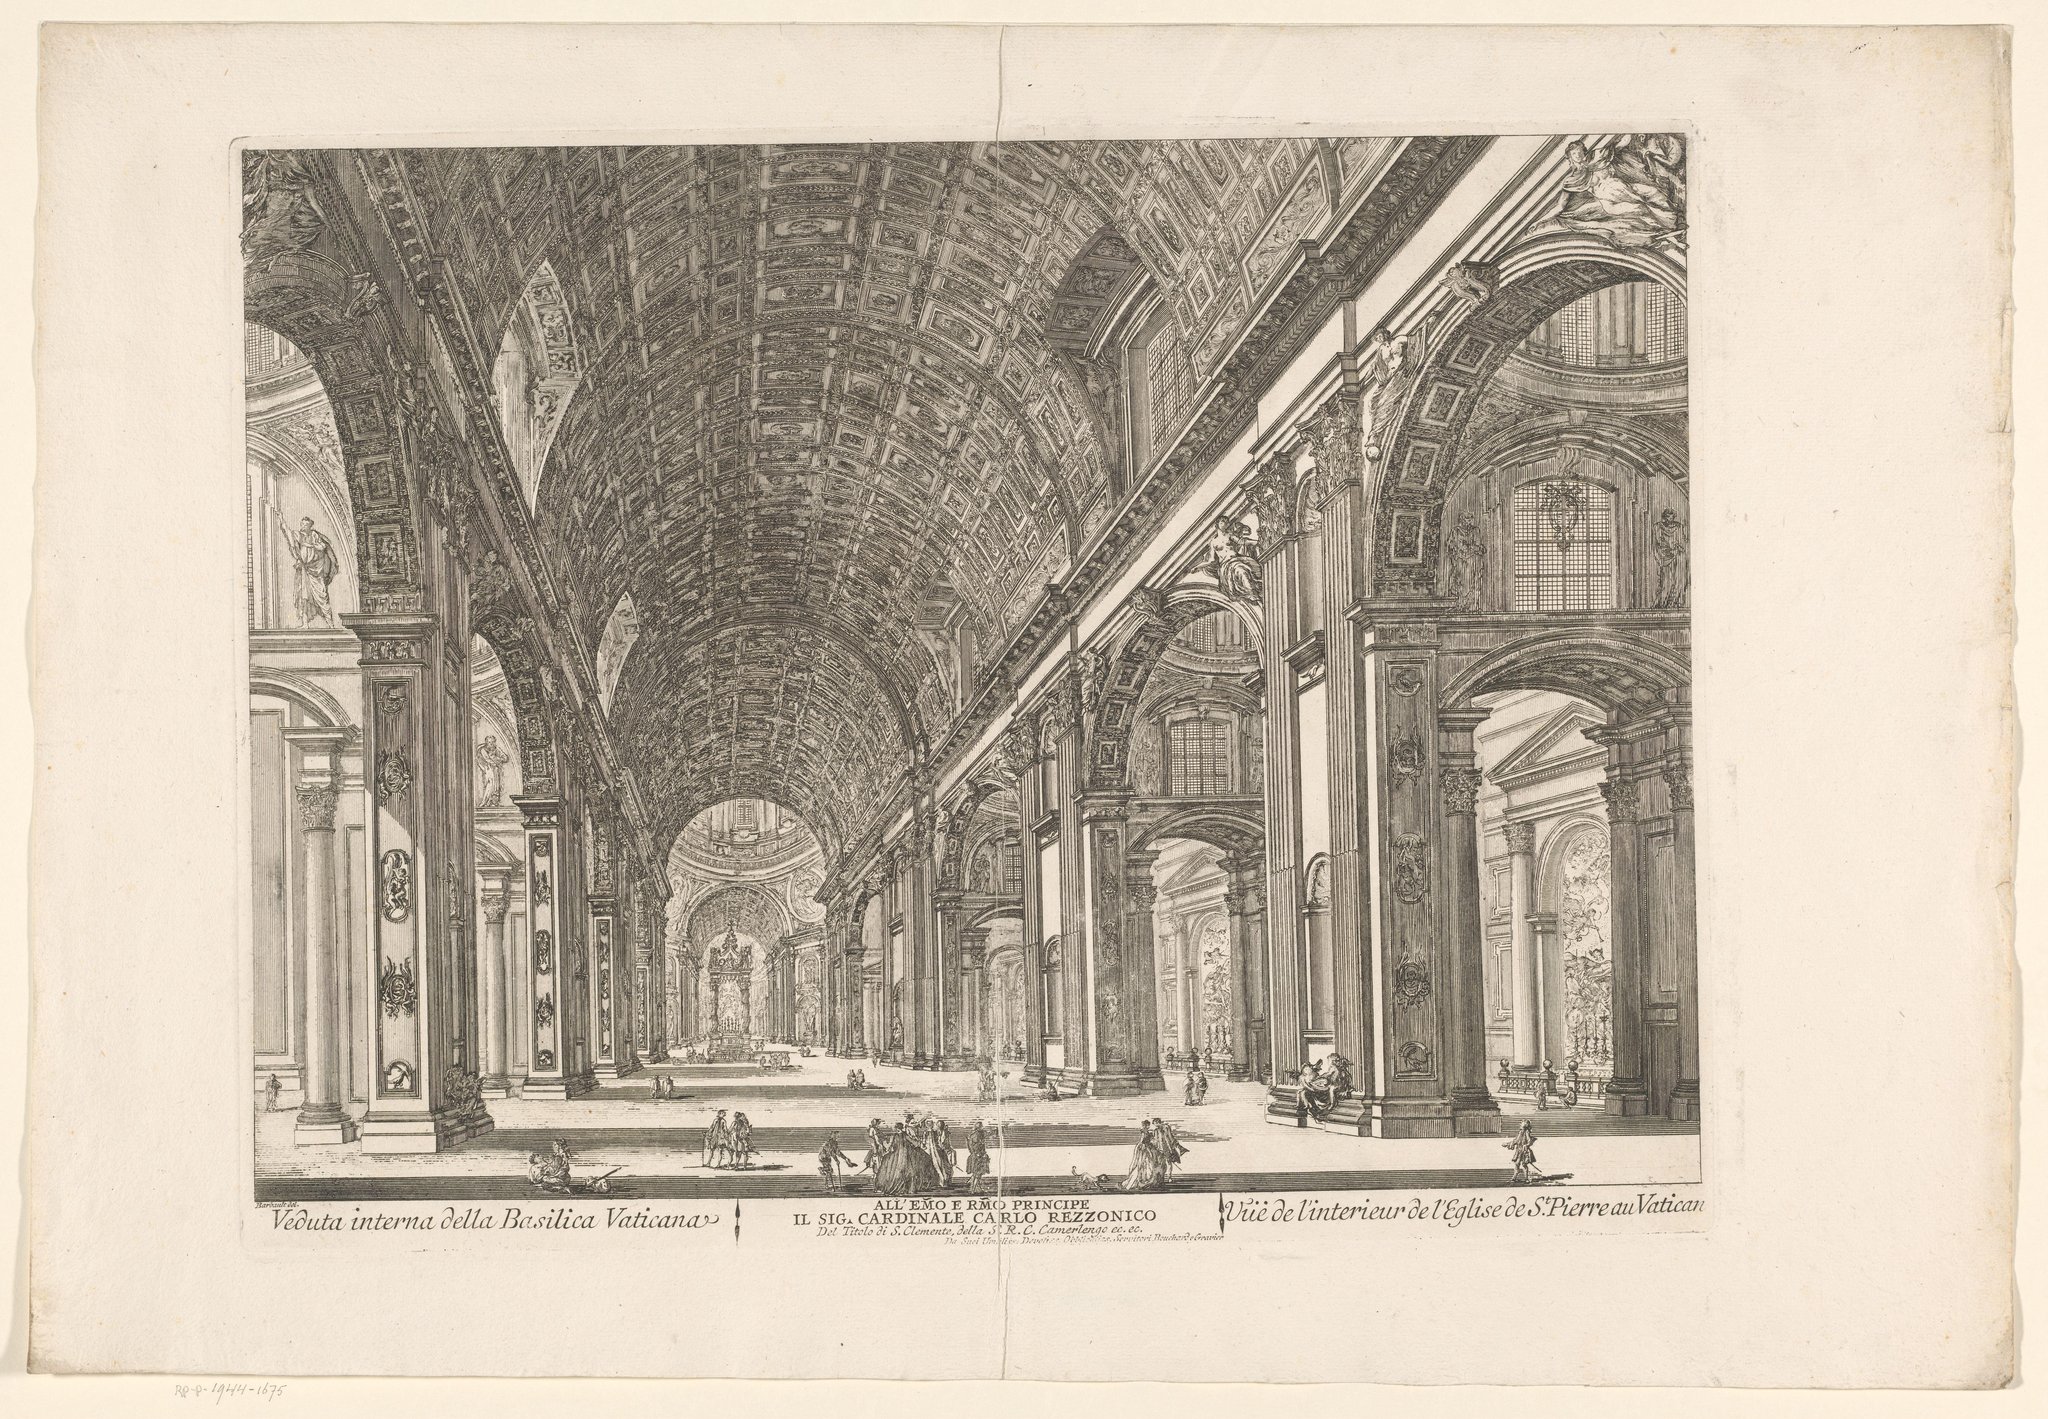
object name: print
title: Veduta interna della Basilica Vaticana / Vuë de l'interieur de l'eglise de St. Pierre au Vatican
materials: paper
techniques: engraving, etching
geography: rome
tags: interior of church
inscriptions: collector's mark: Lugt 2228